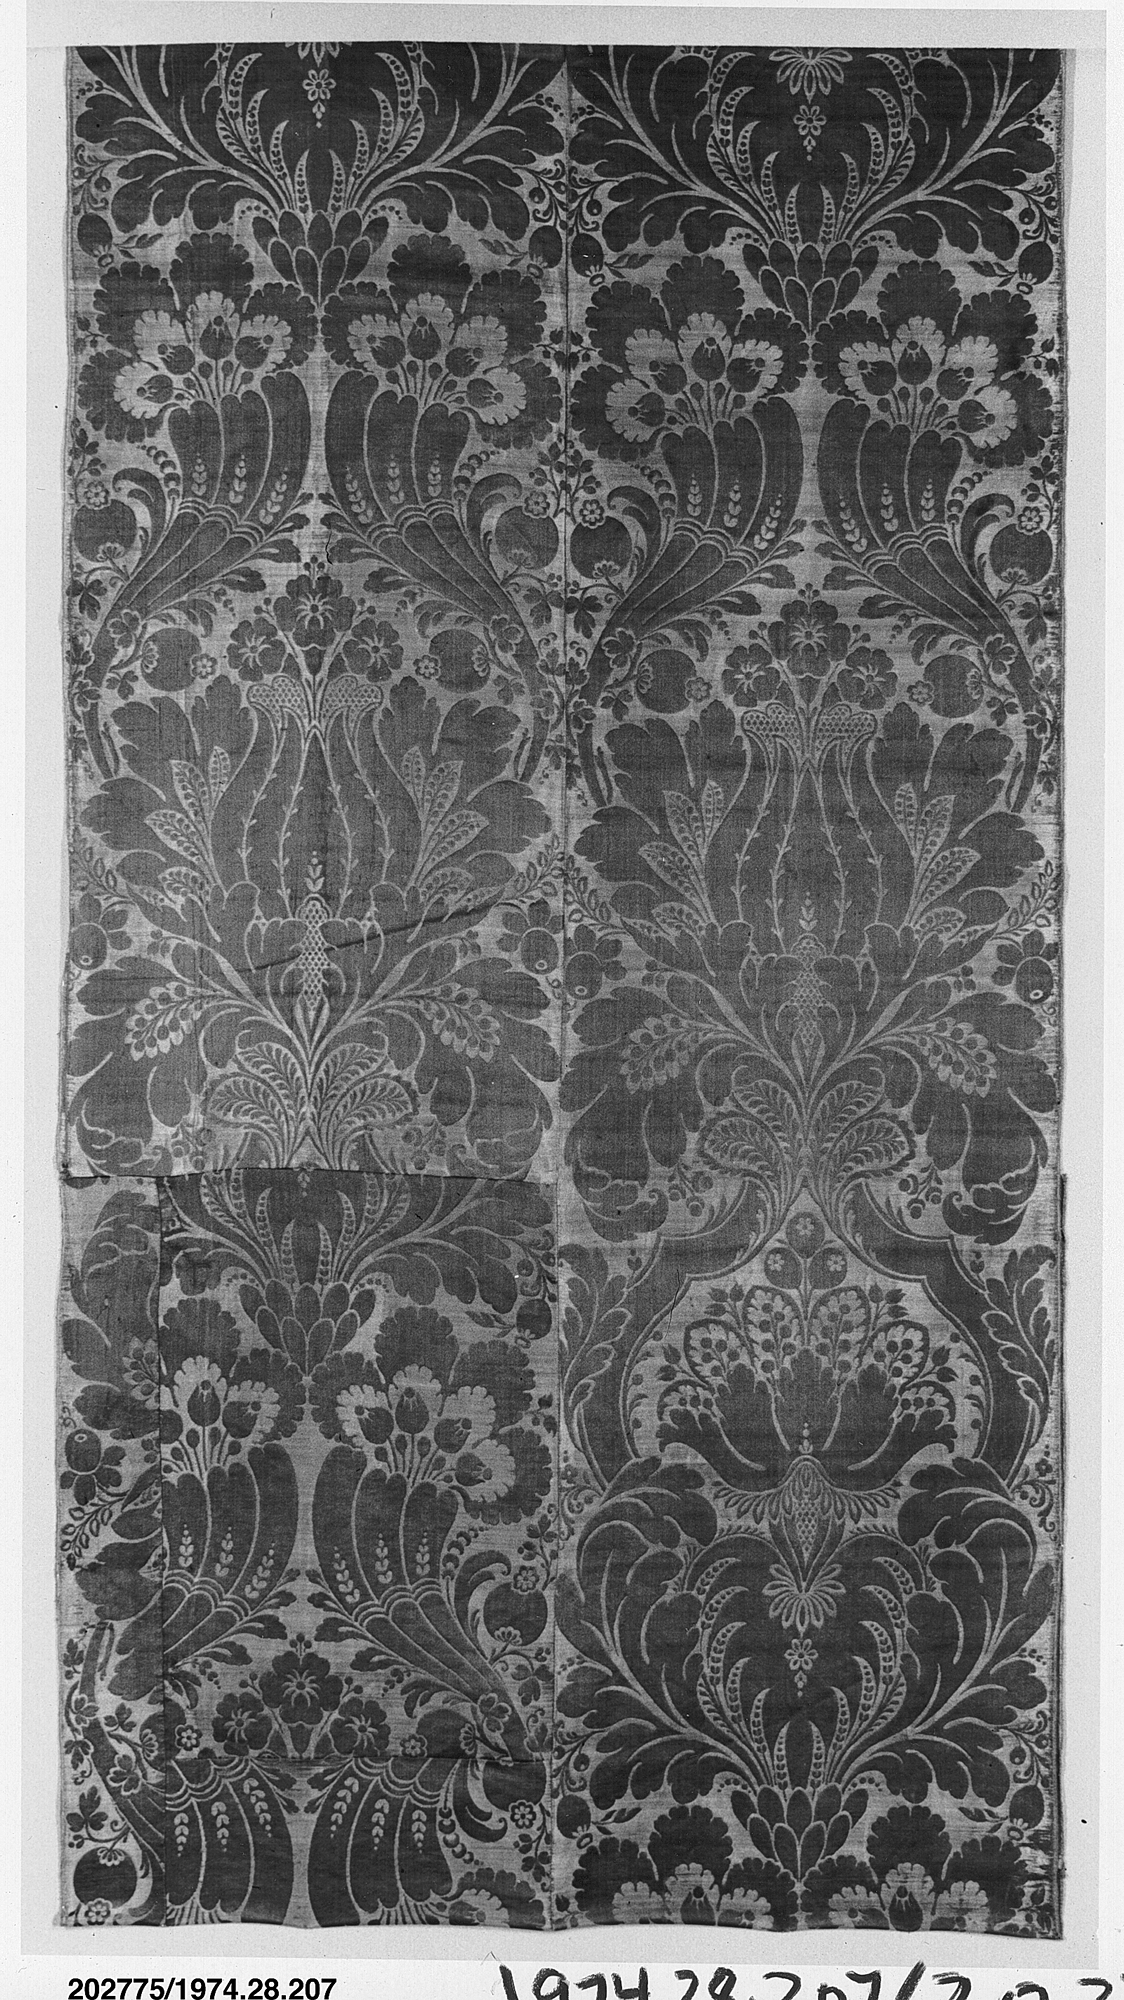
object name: panel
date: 1601-1700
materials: hemp, silk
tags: flowers,leaves